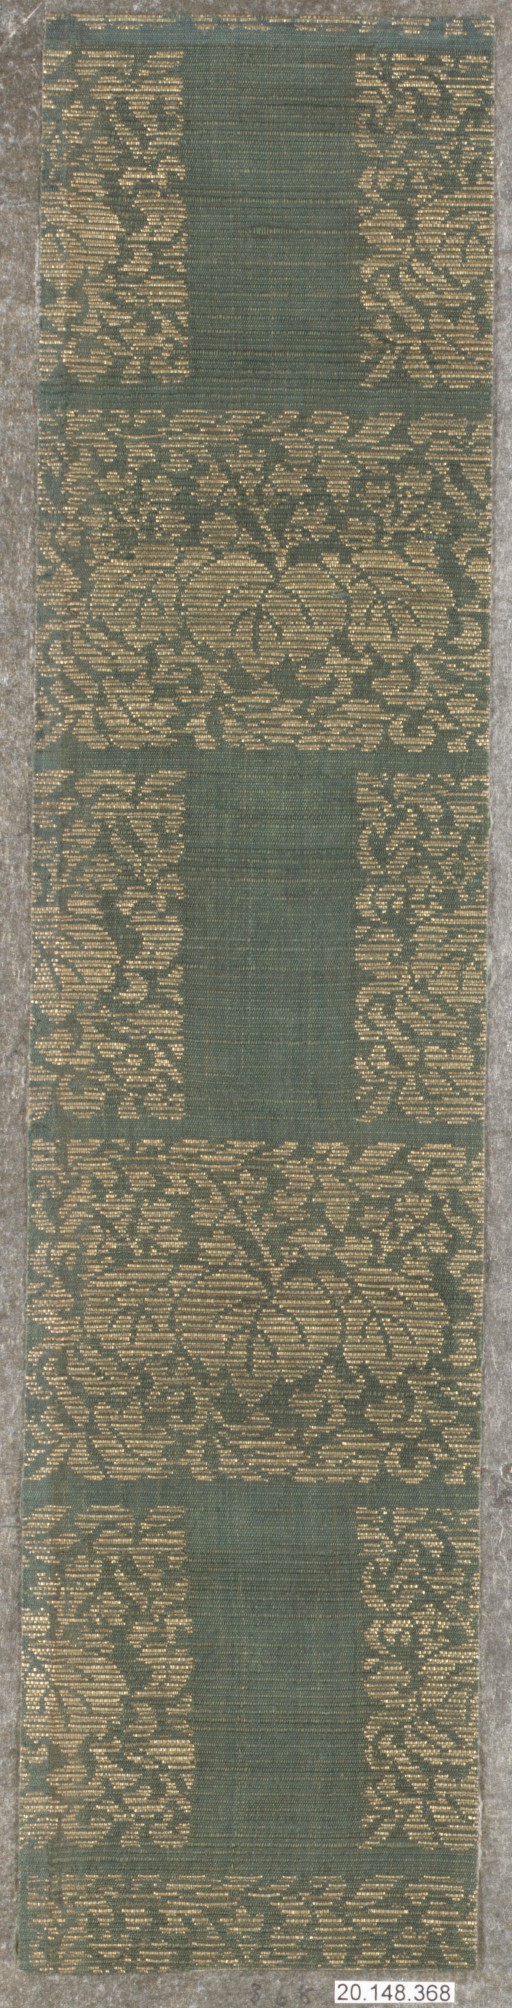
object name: piece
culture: japanese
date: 1701-1800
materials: silk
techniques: compound weave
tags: leaves